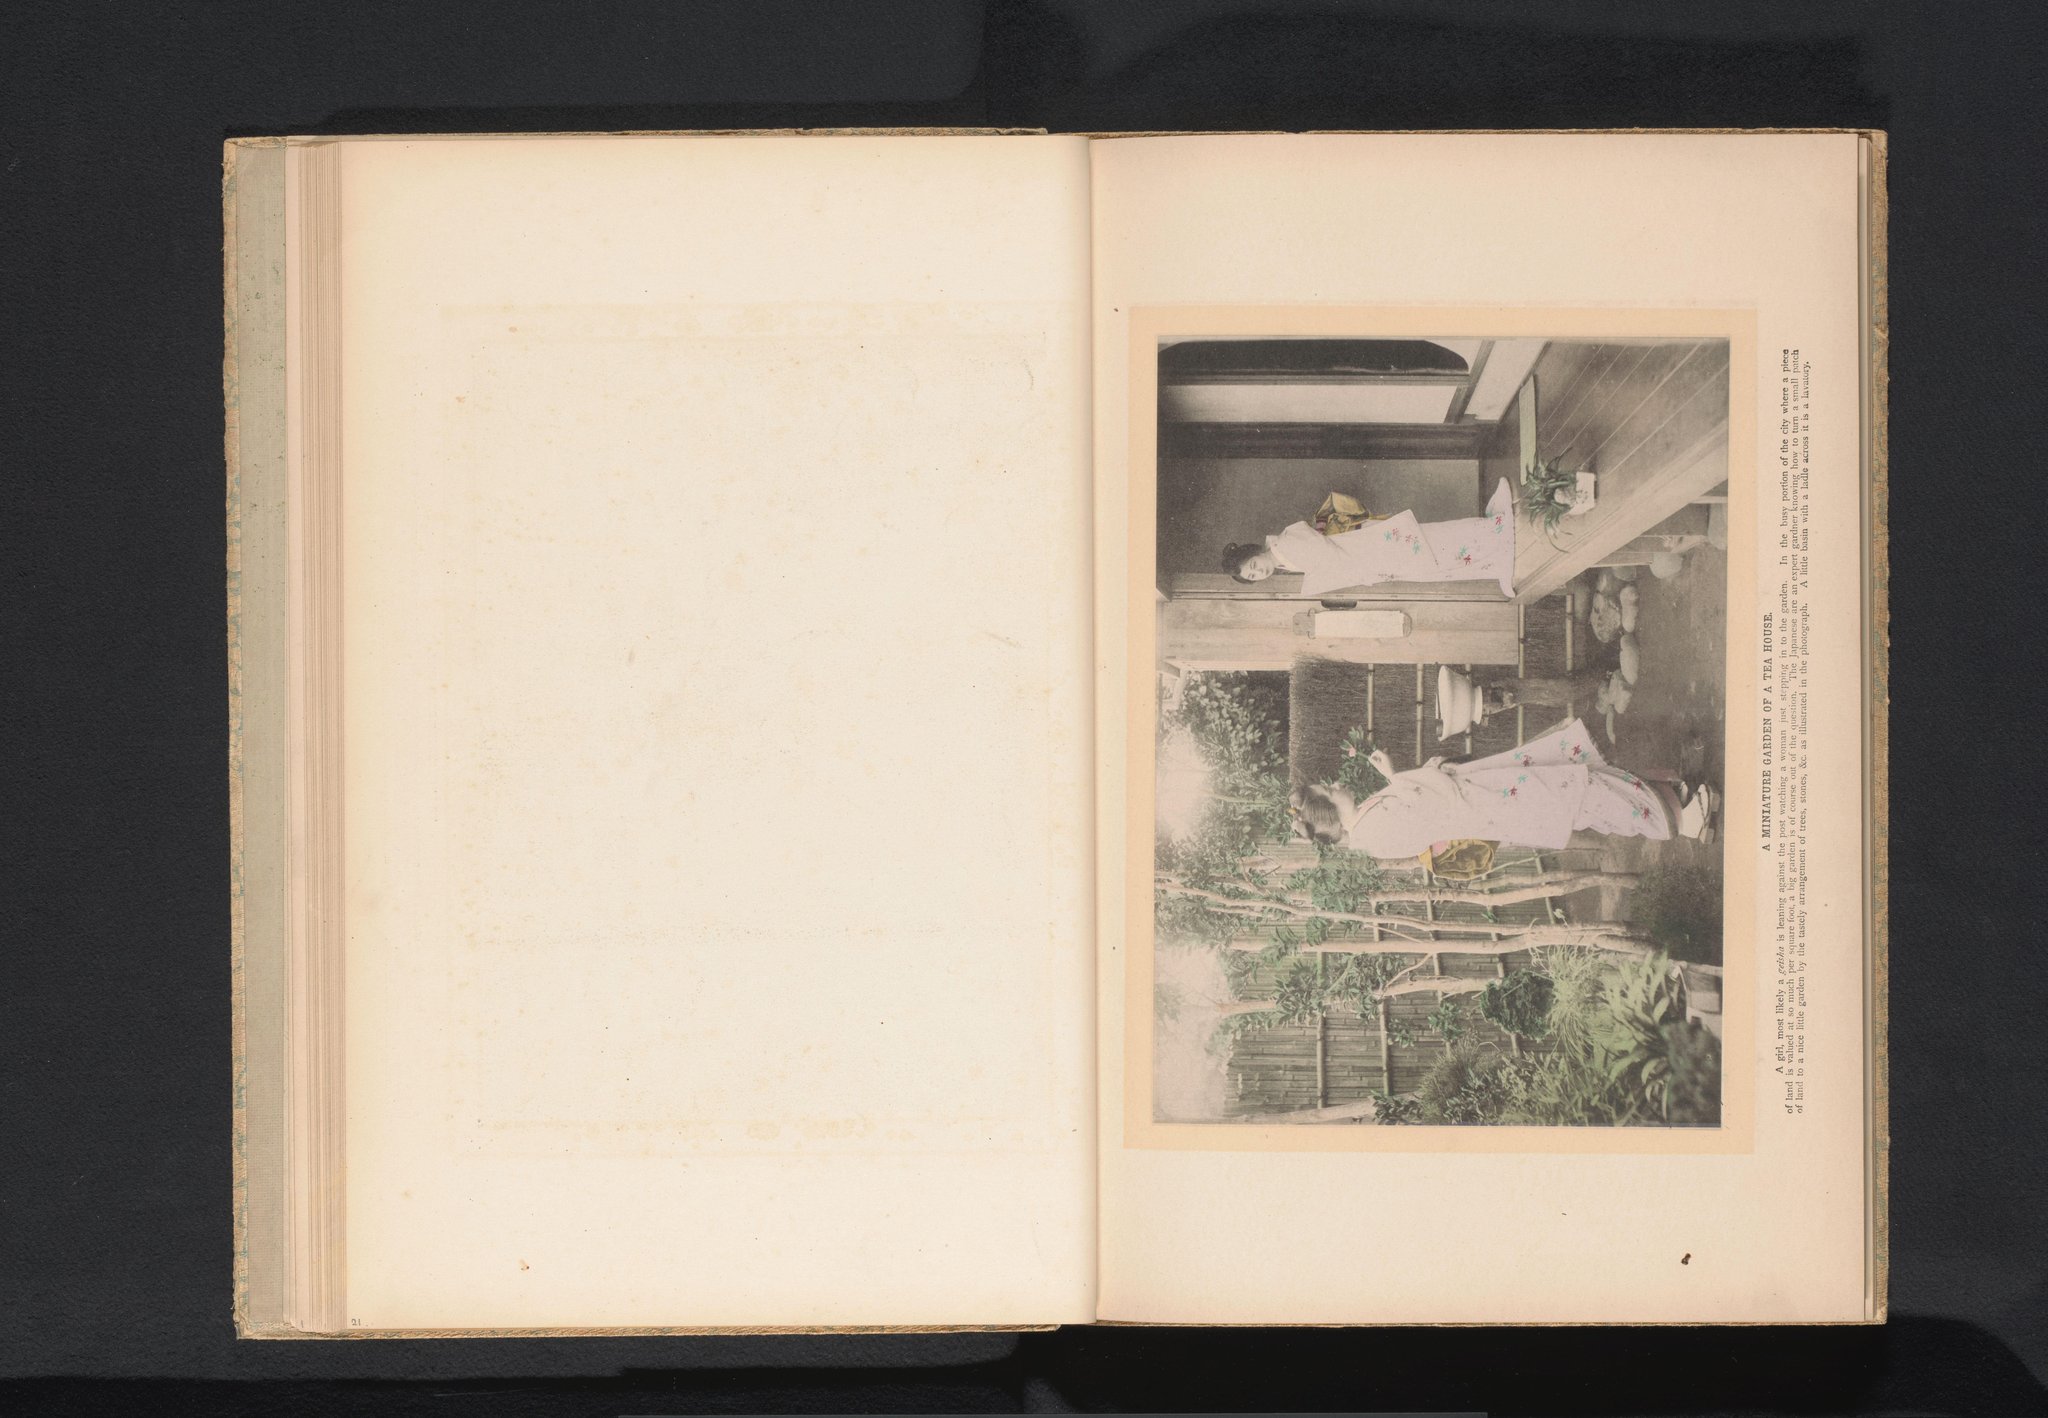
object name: photomechanical print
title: A Miniature Garden of a Tea House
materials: paper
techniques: photograph, lithograph, hand coloring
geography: japan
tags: garden, inn, coffee-house, public house, etc., adult woman (+ two persons), japan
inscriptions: inscription: ‘A girl (...) a lavatory.’